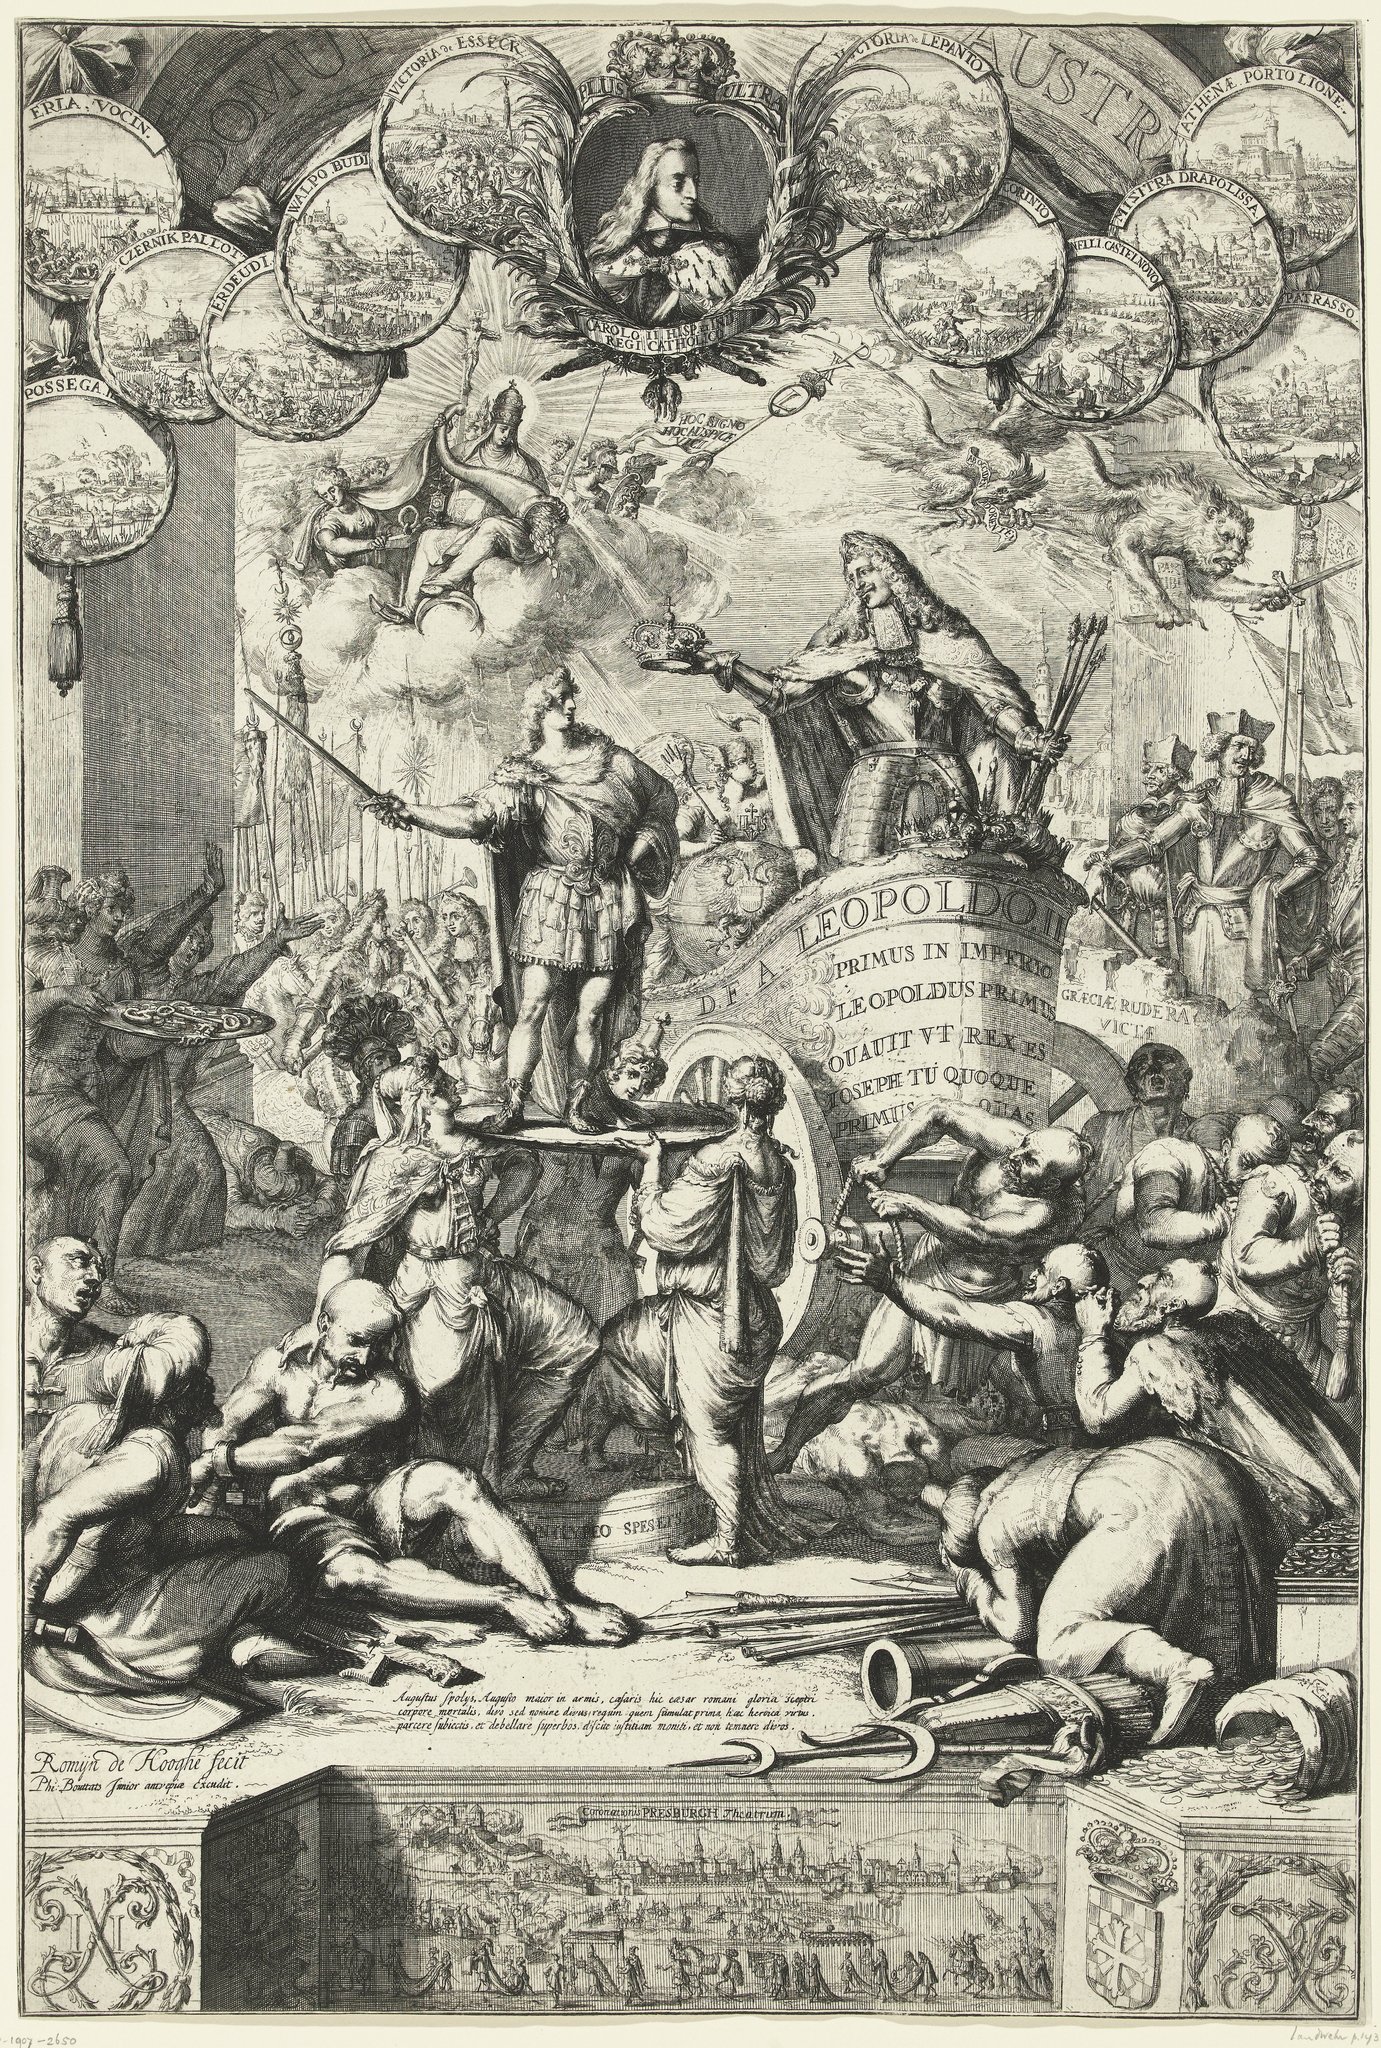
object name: print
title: Allegorie op de troonopvolging van Leopold I door zijn zoon Jozef I, 1687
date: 1687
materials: paper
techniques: etching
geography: antwerp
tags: leopold i (keizer van duitsland), karel ii (koning van spanje), jozef i (duits keizer), coronation of a ruler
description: Allegorie op de troonopvolging van Leopold I door zijn zoon Jozef I, 1687. Leopold I (foutief aan geduid als Leopold II) staat op een triomfwagen en geeft zijn koningskroon van Hongarije door aan Jozef I. De triomfwagen wordt getrokken door Turken. Bovenin staat een medaillon met een portret van Karel II van Spanje met aan weerszijden afbeeldingen van de overwinningen op de Turken. Onderin staat een voorstelling van de kroningsstoet in Presburgh, het huidige Bratislava.